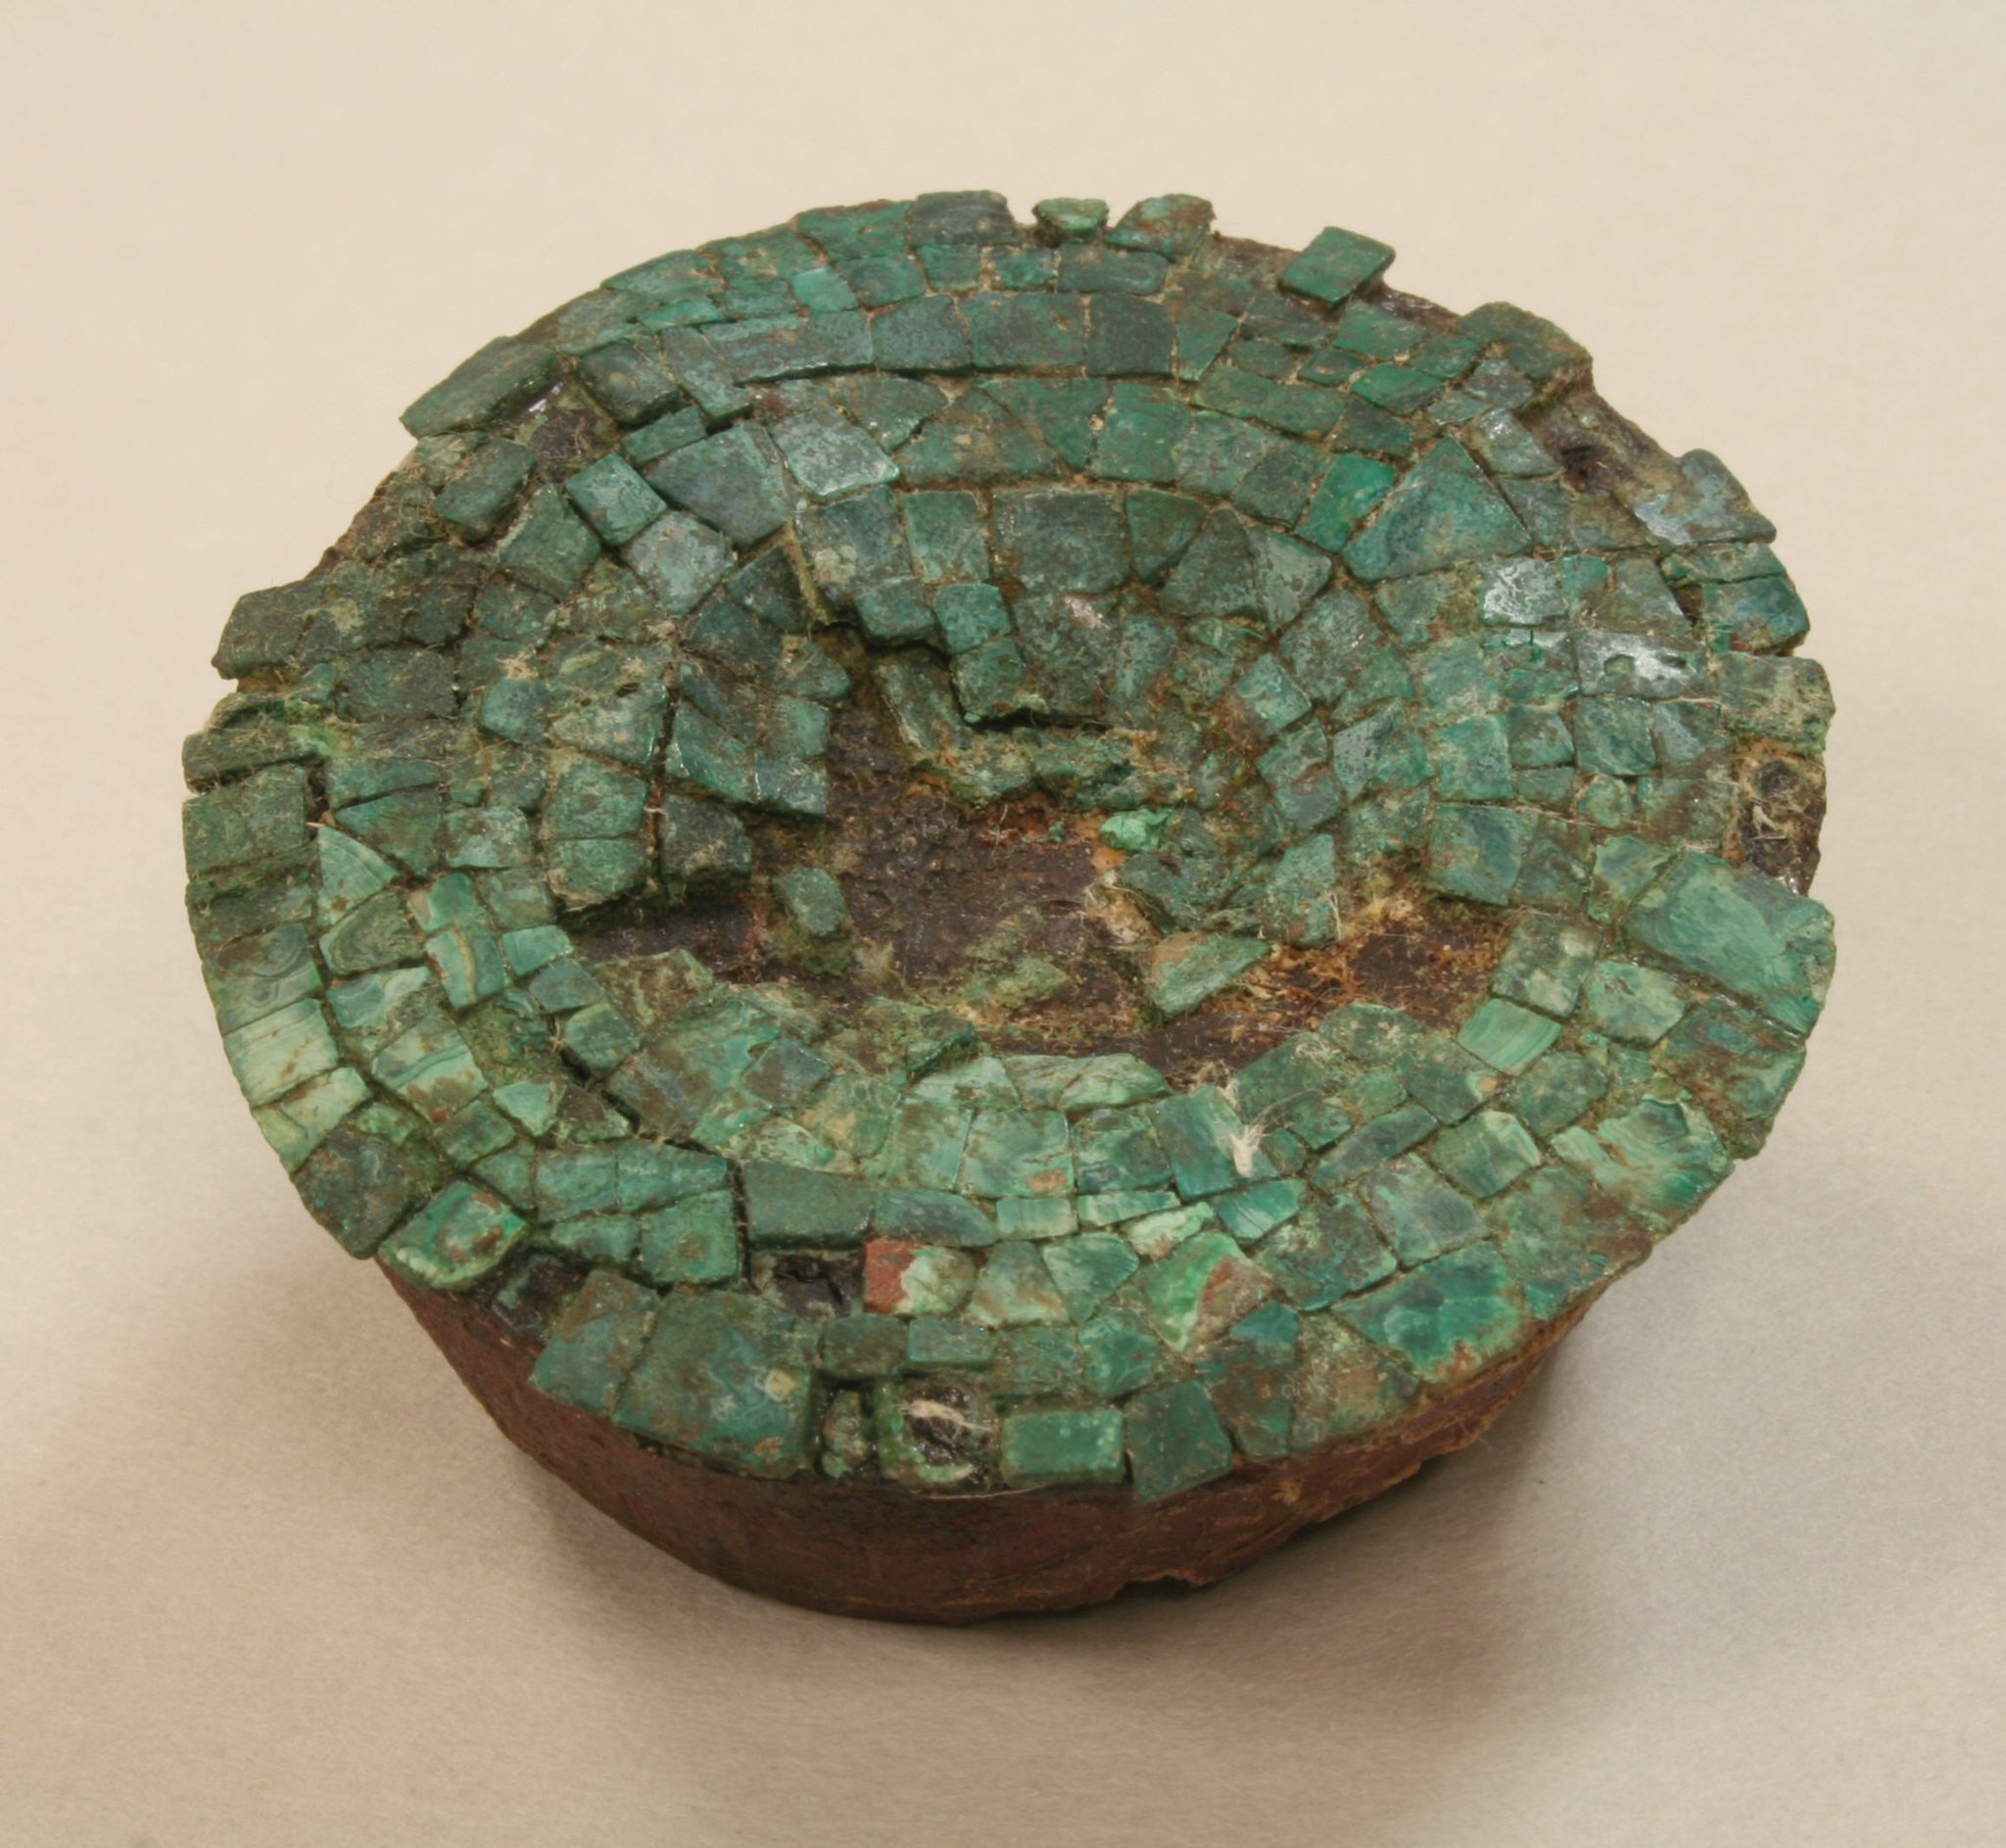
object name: disk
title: Earflare Disk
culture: mexica, aztec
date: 1401-1600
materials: wood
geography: mexico